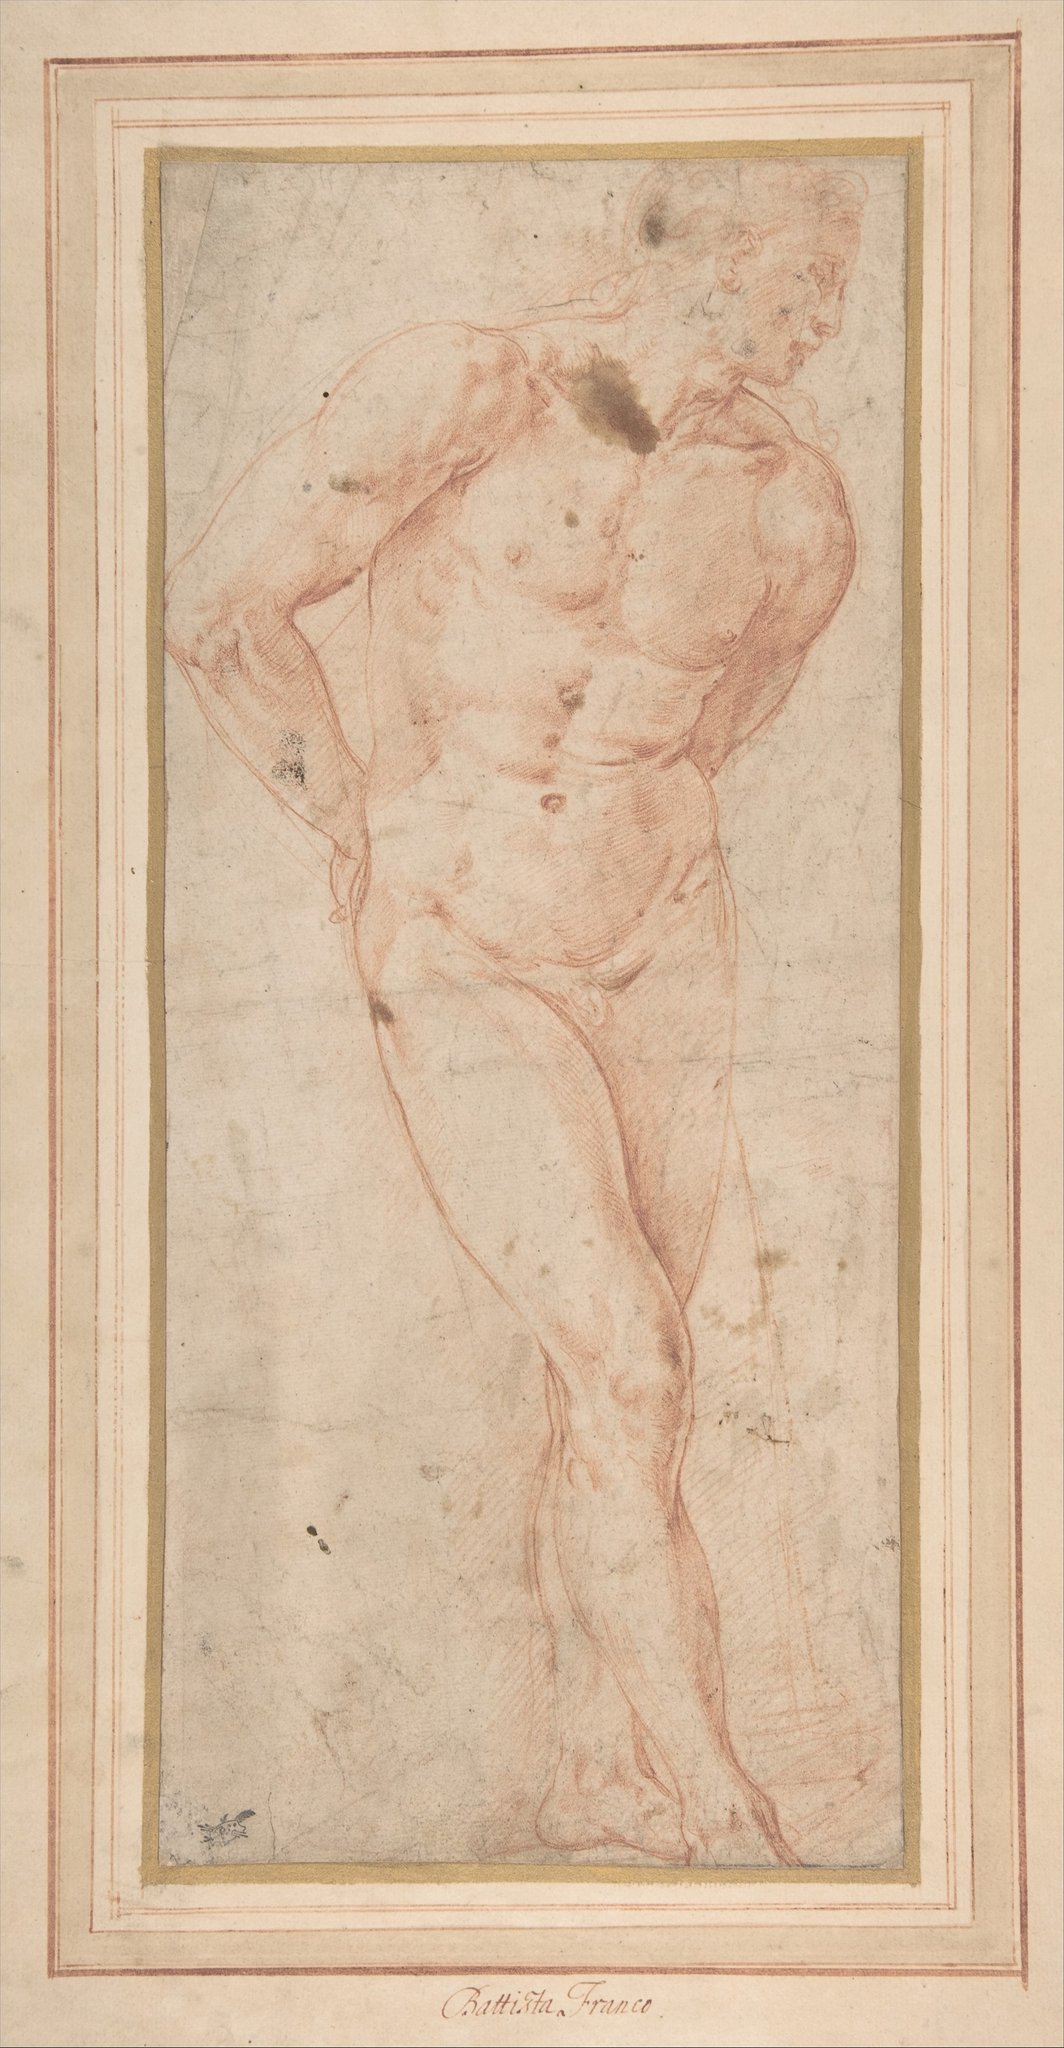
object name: portfolio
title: Standing Male Nude with Hands behind Back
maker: battista franco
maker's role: artist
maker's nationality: italian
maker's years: 1510-1561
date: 1510-1561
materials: chalk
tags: male nudes